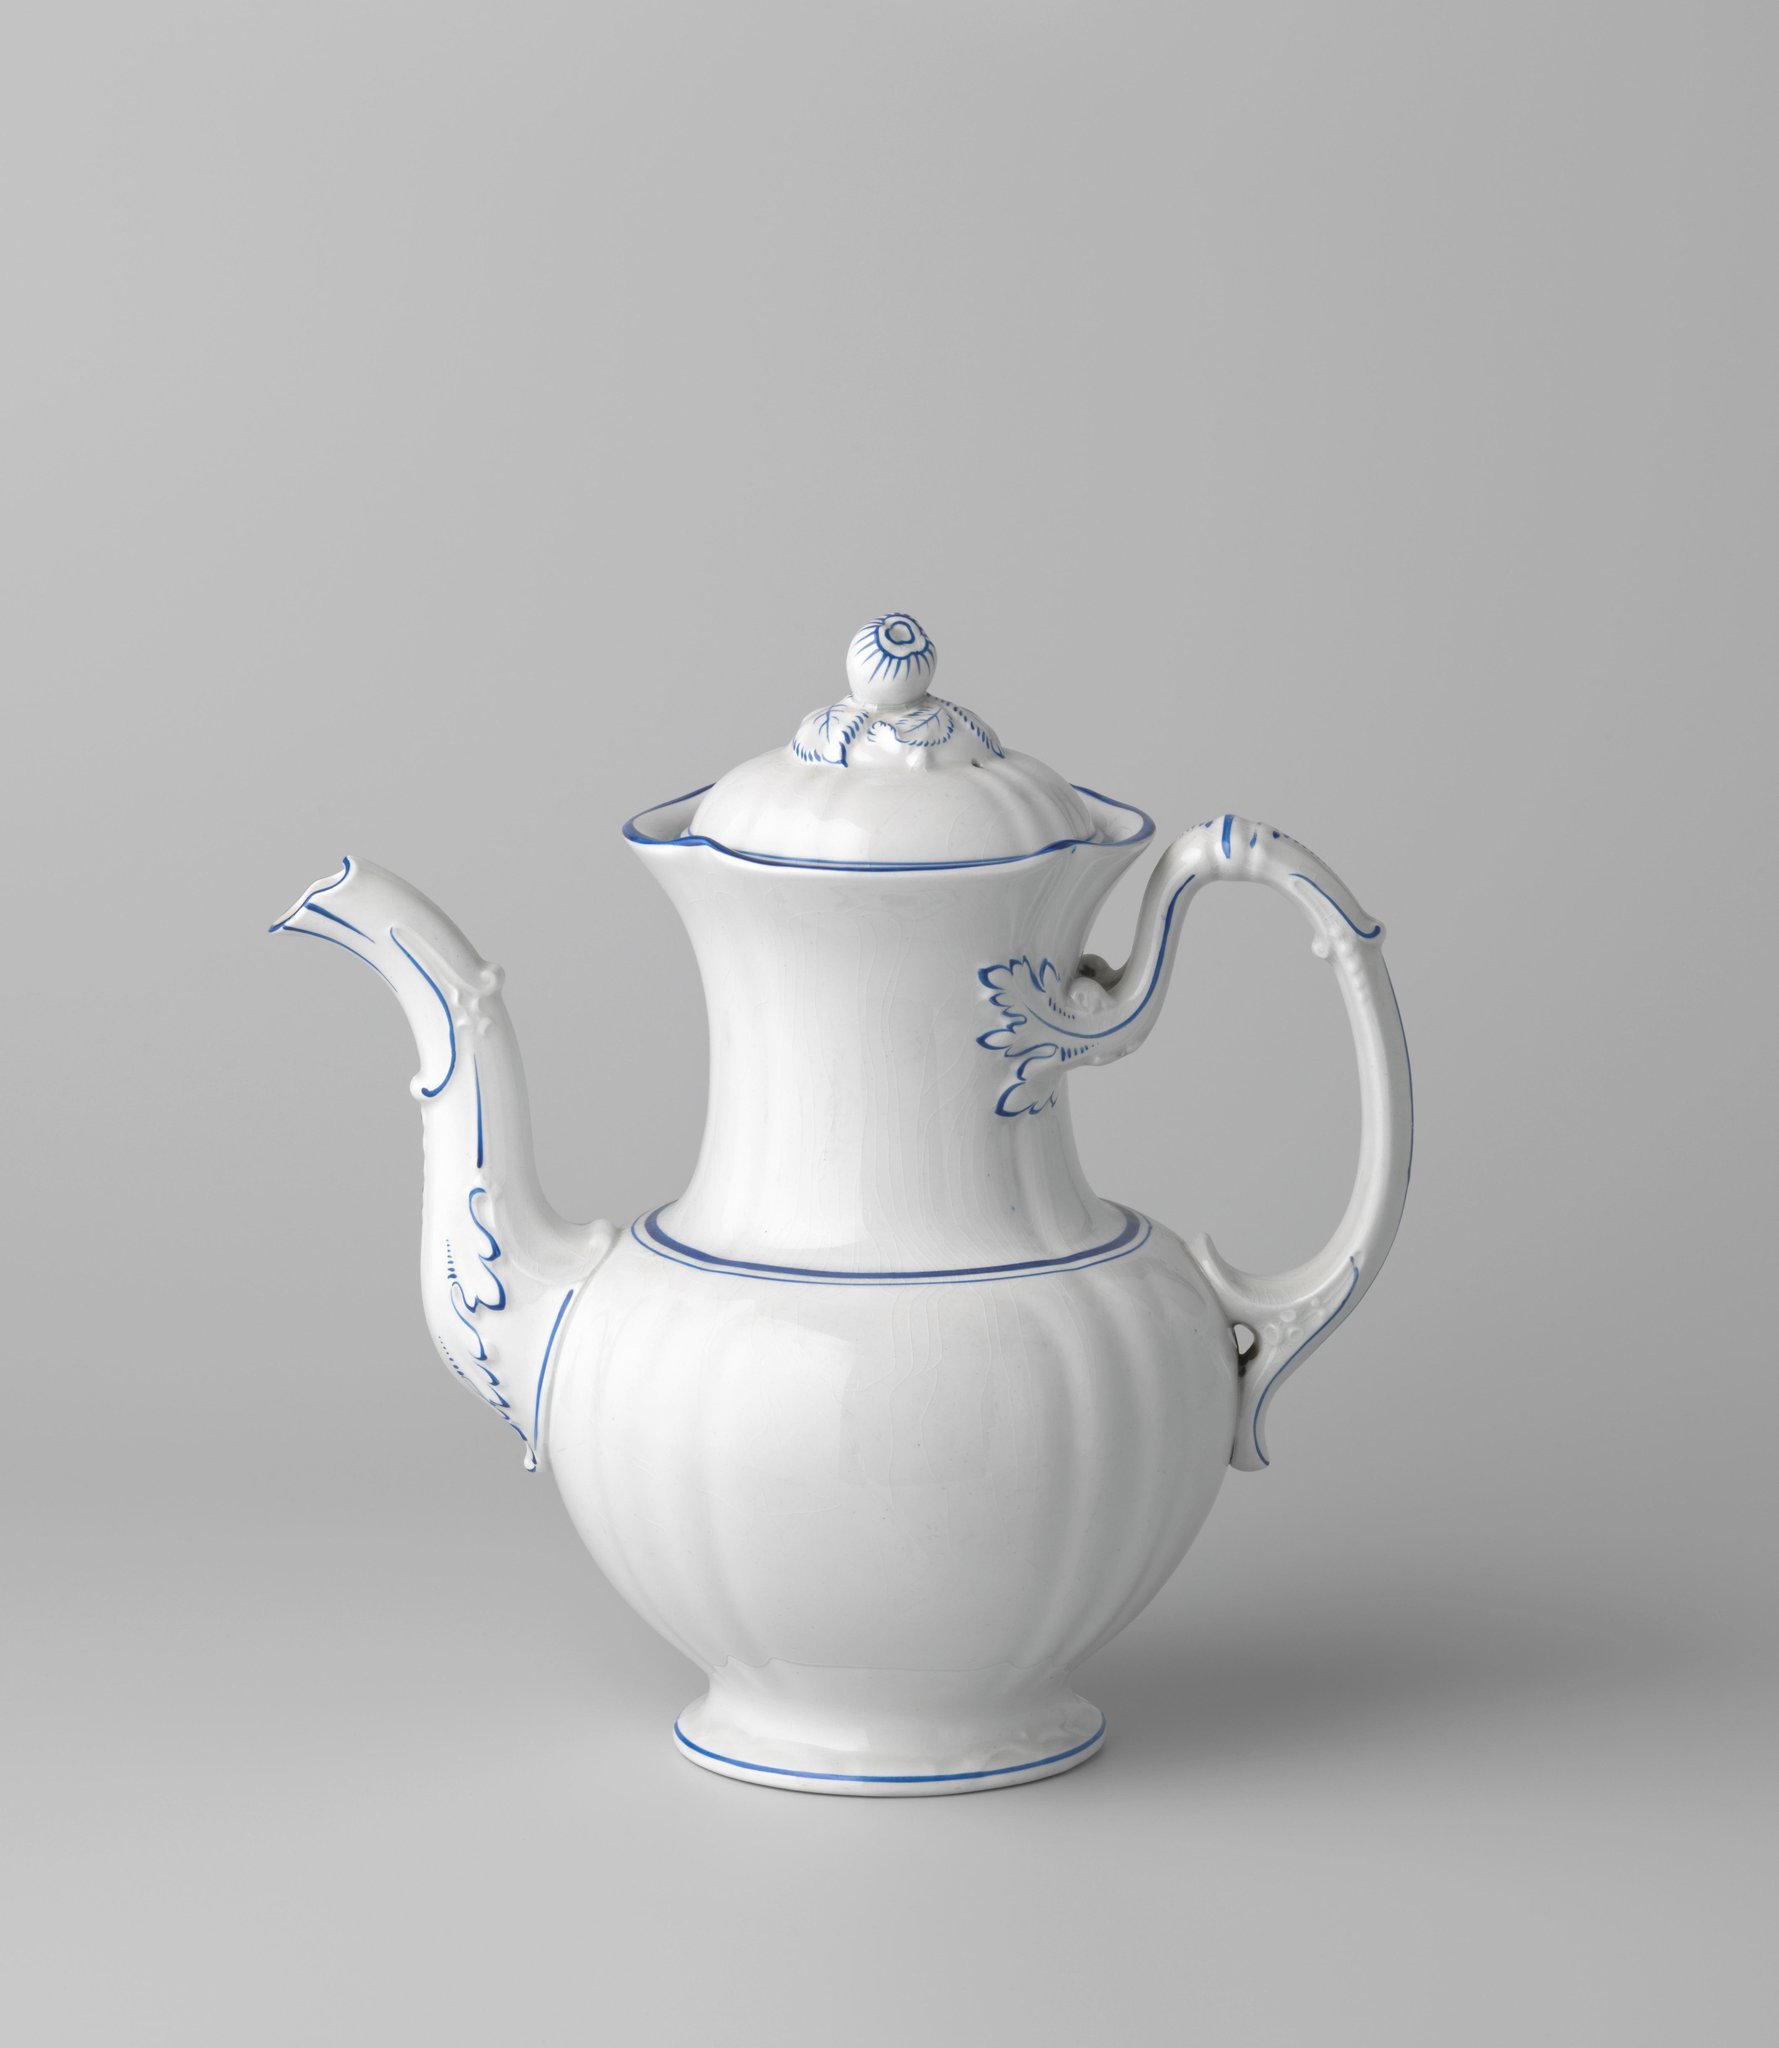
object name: coffee pot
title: Koffiepot, wit, met blauwe biezen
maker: petrus regout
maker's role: plateelbakker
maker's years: 1801-1879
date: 1860-1890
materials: creamware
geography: maastricht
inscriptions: check stamp: ‘P. REGOUT // MAASTRICHT // 16 X’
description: Koffiepot van aardewerk, behorend bij een koffie- en theeservies, wit, met blauwe biezen.